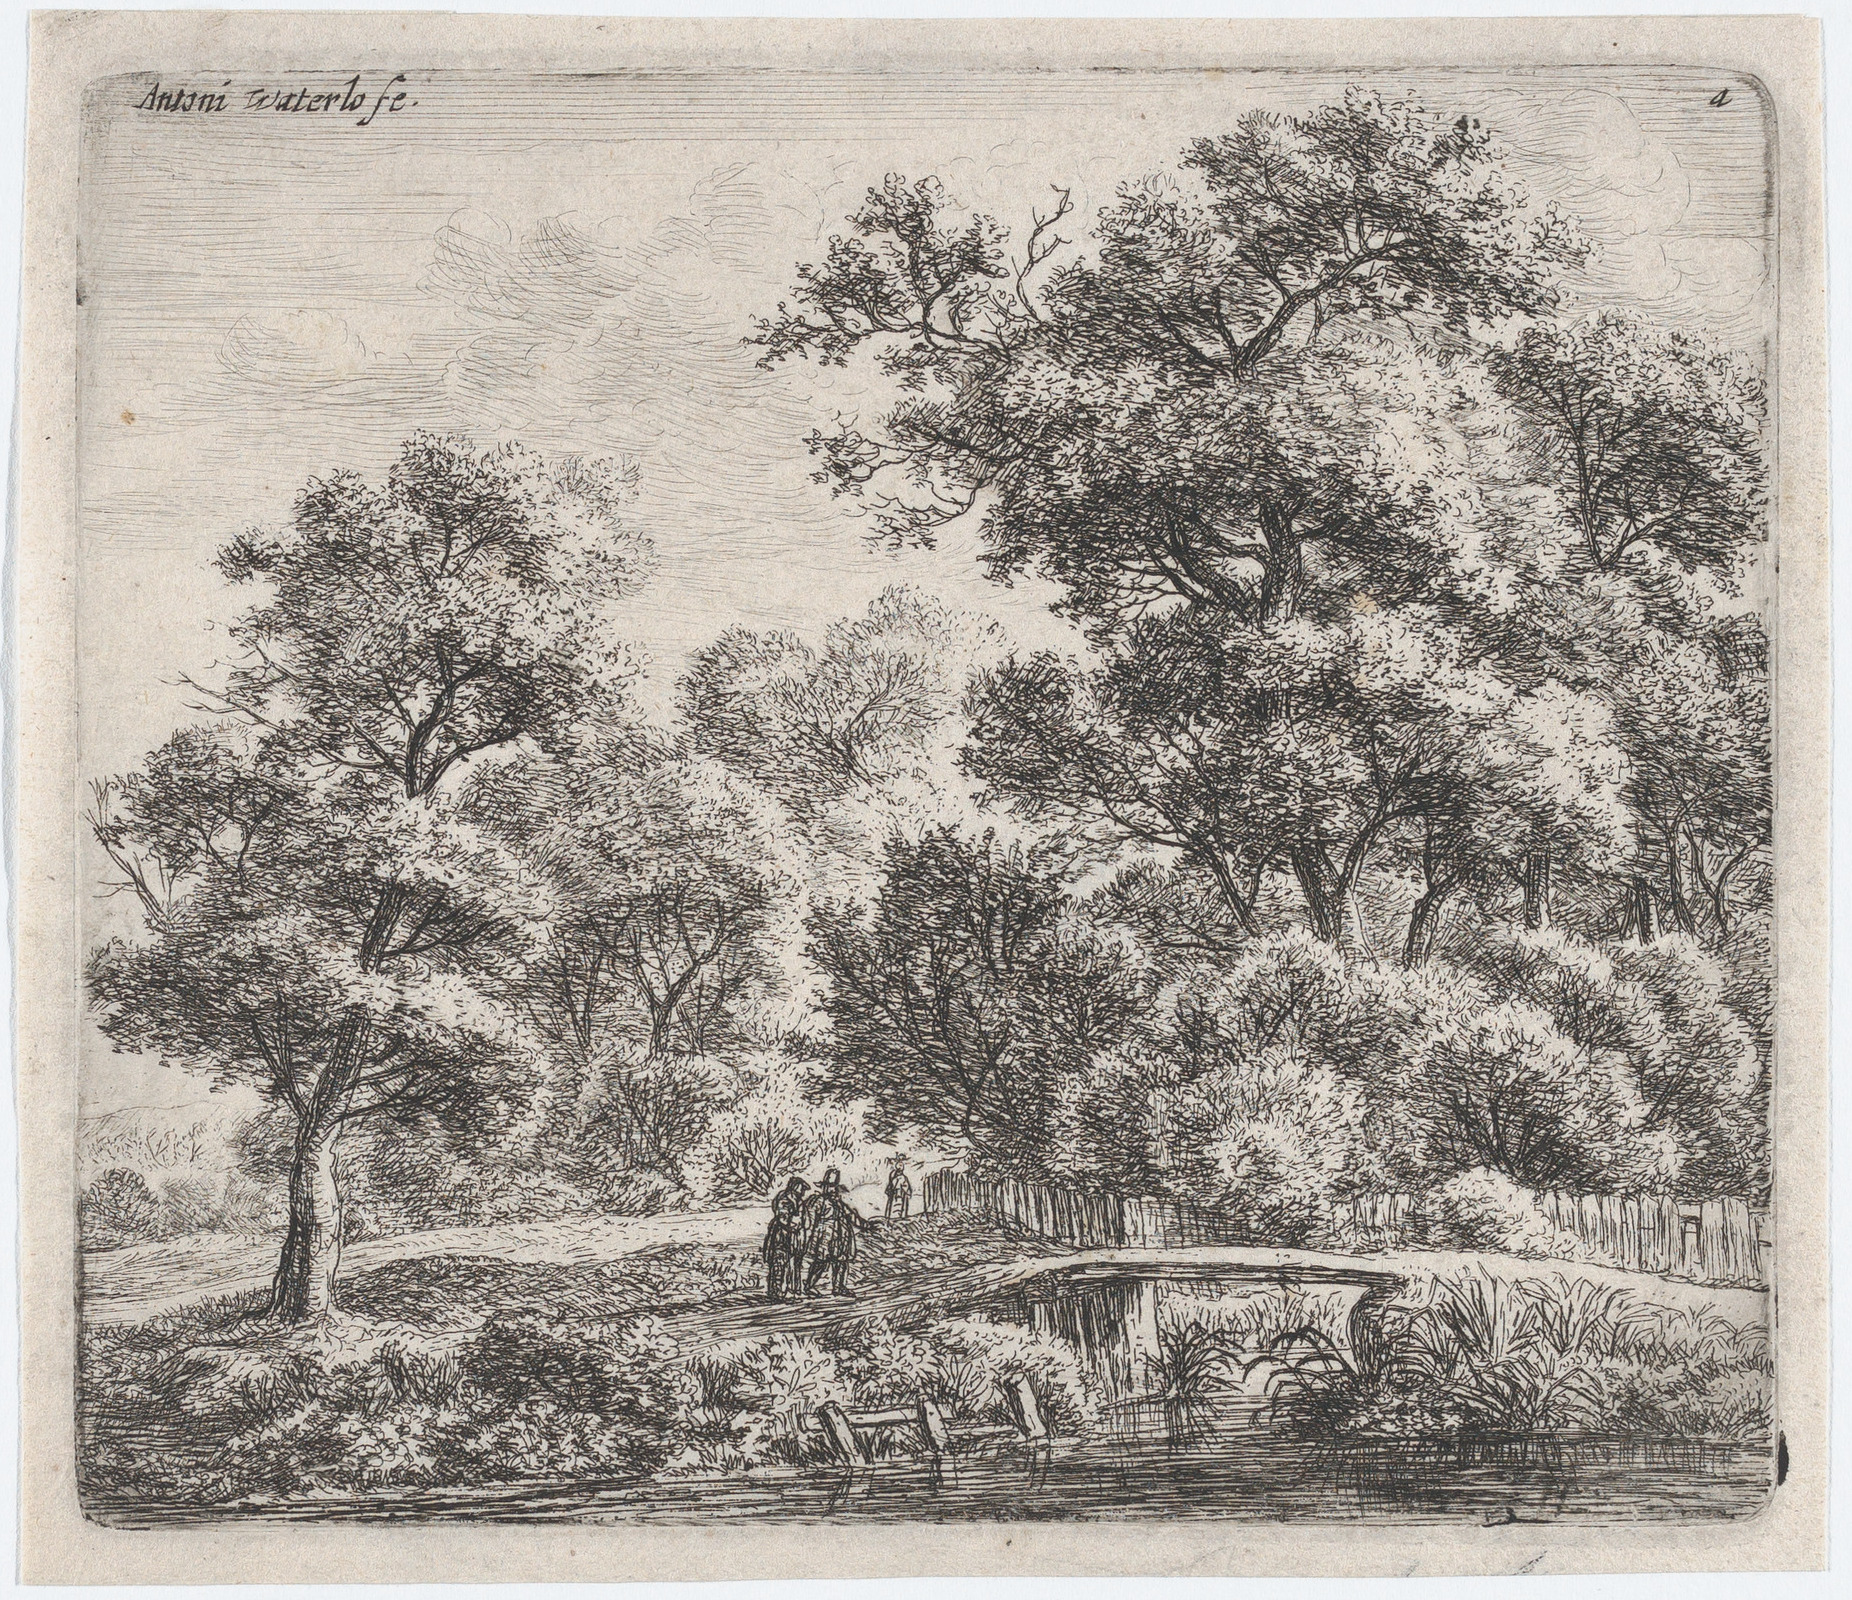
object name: print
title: A Man and a Woman Near a Small Bridge (L'Homme et la Femme Près du Petit Pont)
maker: anthonie waterloo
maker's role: artist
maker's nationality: dutch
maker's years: 1609-1690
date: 1601-1700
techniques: etching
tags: bridges,men,trees